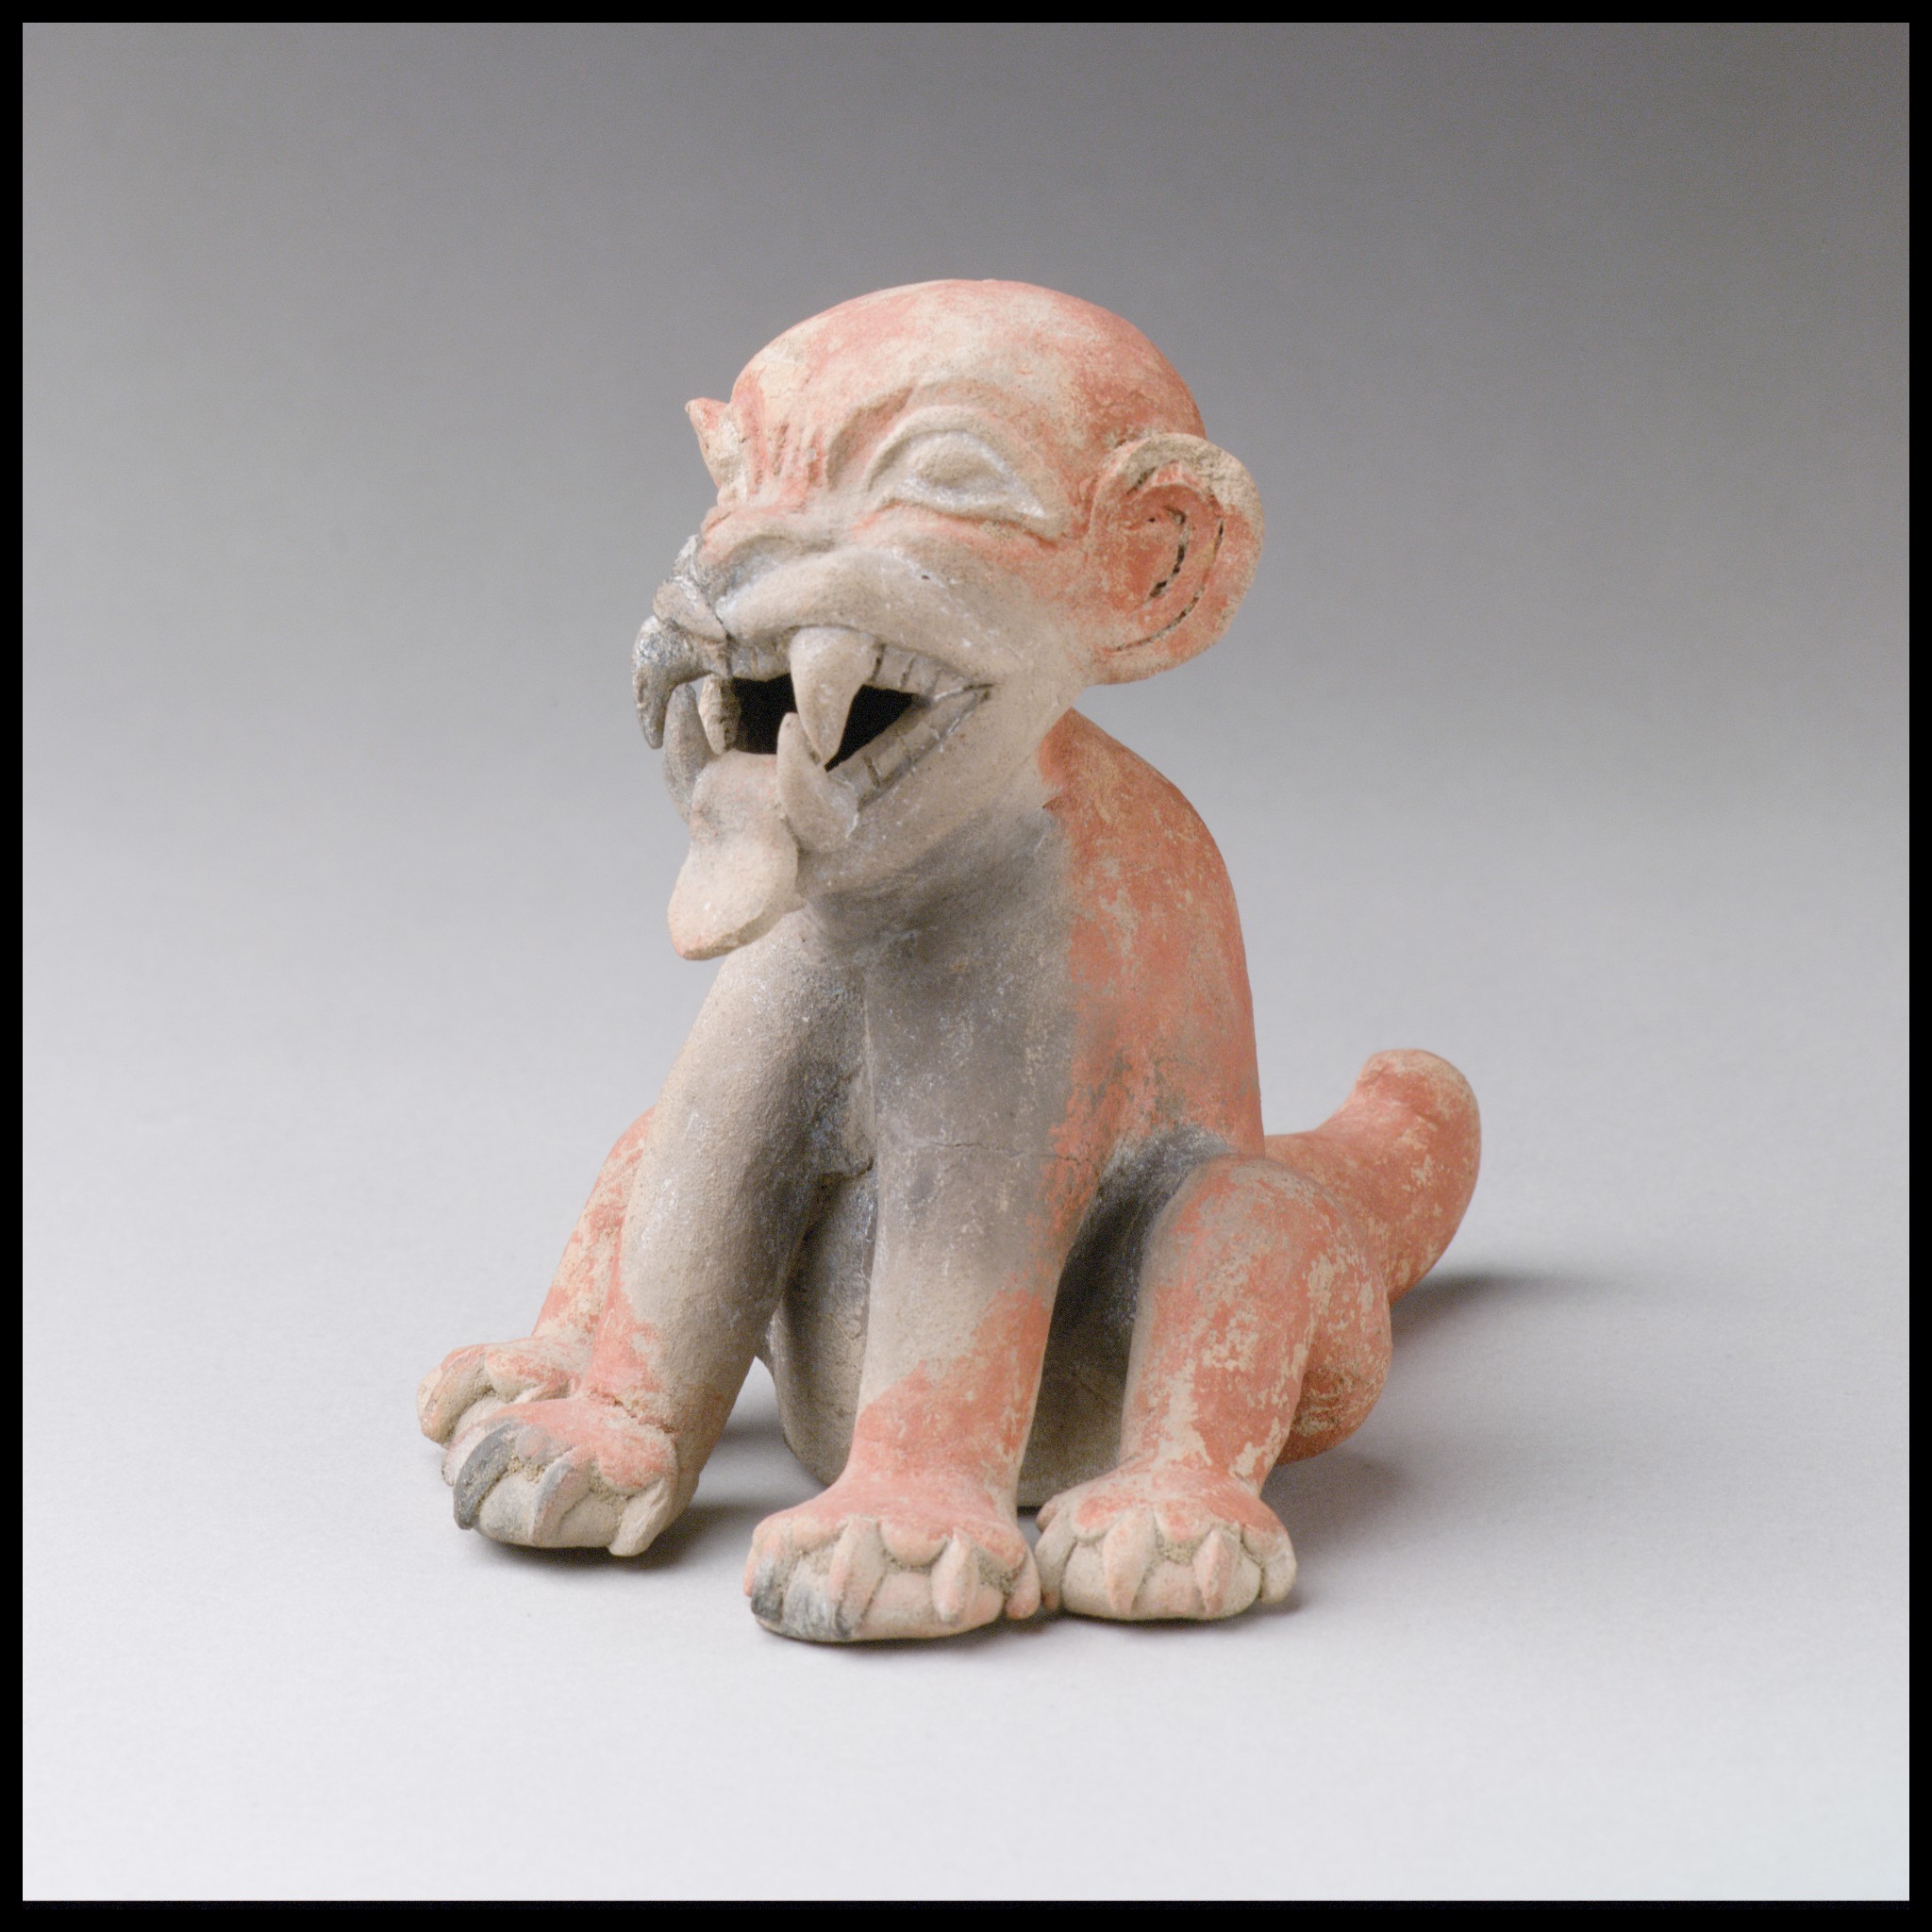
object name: figure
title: Seated feline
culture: tolita-tumaco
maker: tolita-tumaco artist(s)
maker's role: artist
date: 500 BCE-300 CE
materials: ceramic, paint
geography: colombia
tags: animals